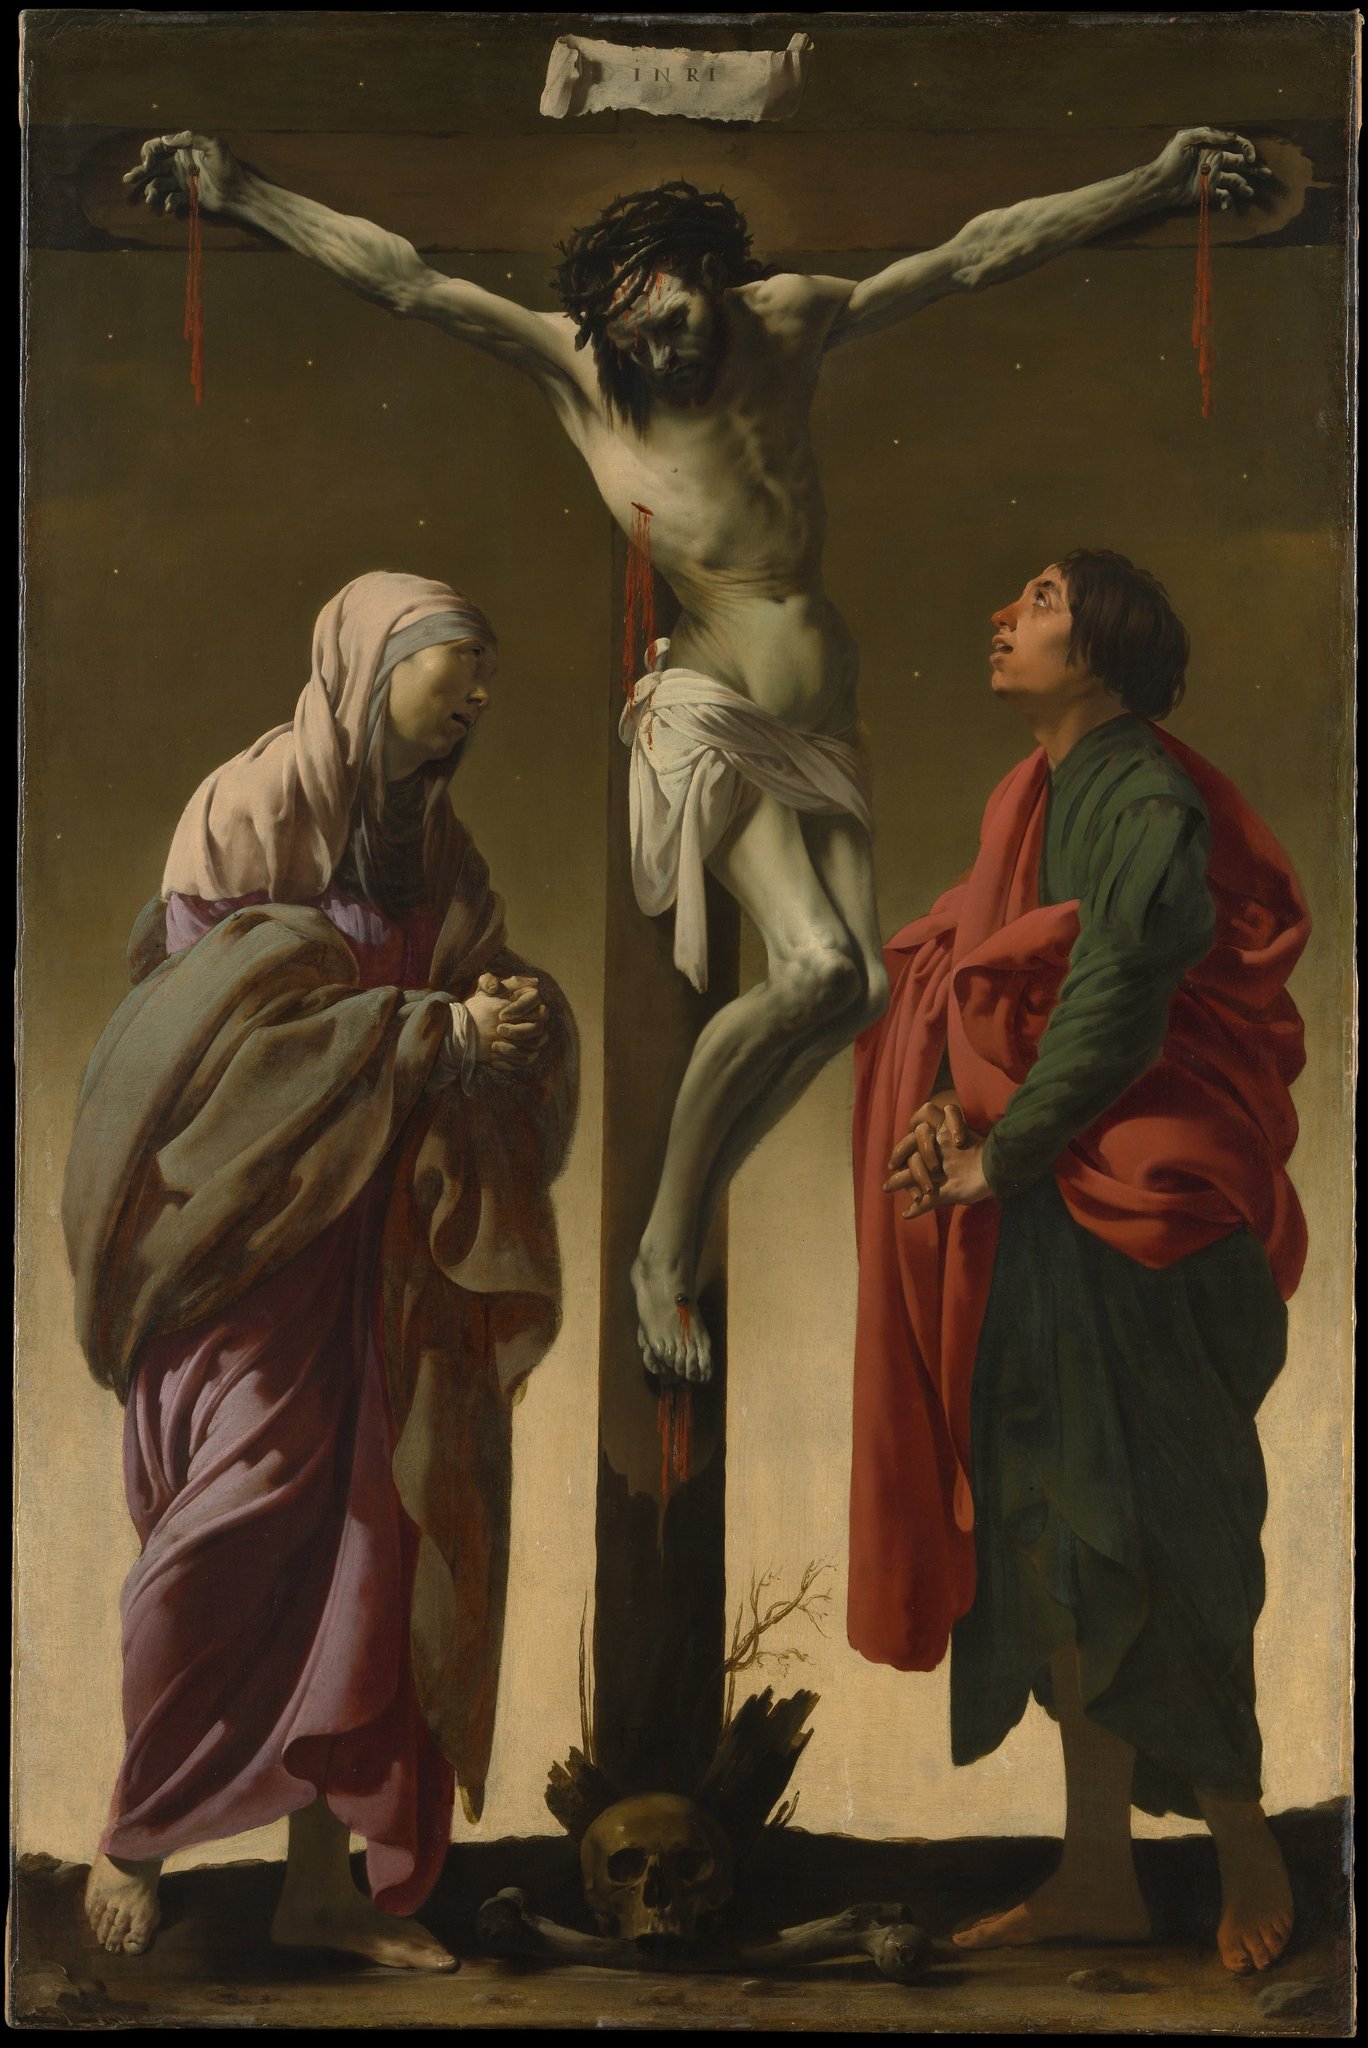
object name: painting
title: The Crucifixion with the Virgin and Saint John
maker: hendrick ter brugghen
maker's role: artist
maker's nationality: dutch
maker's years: 1588-1629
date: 1624-1625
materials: canvas, oil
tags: skulls,christ,saint john the evangelist,virgin mary,crucifixion